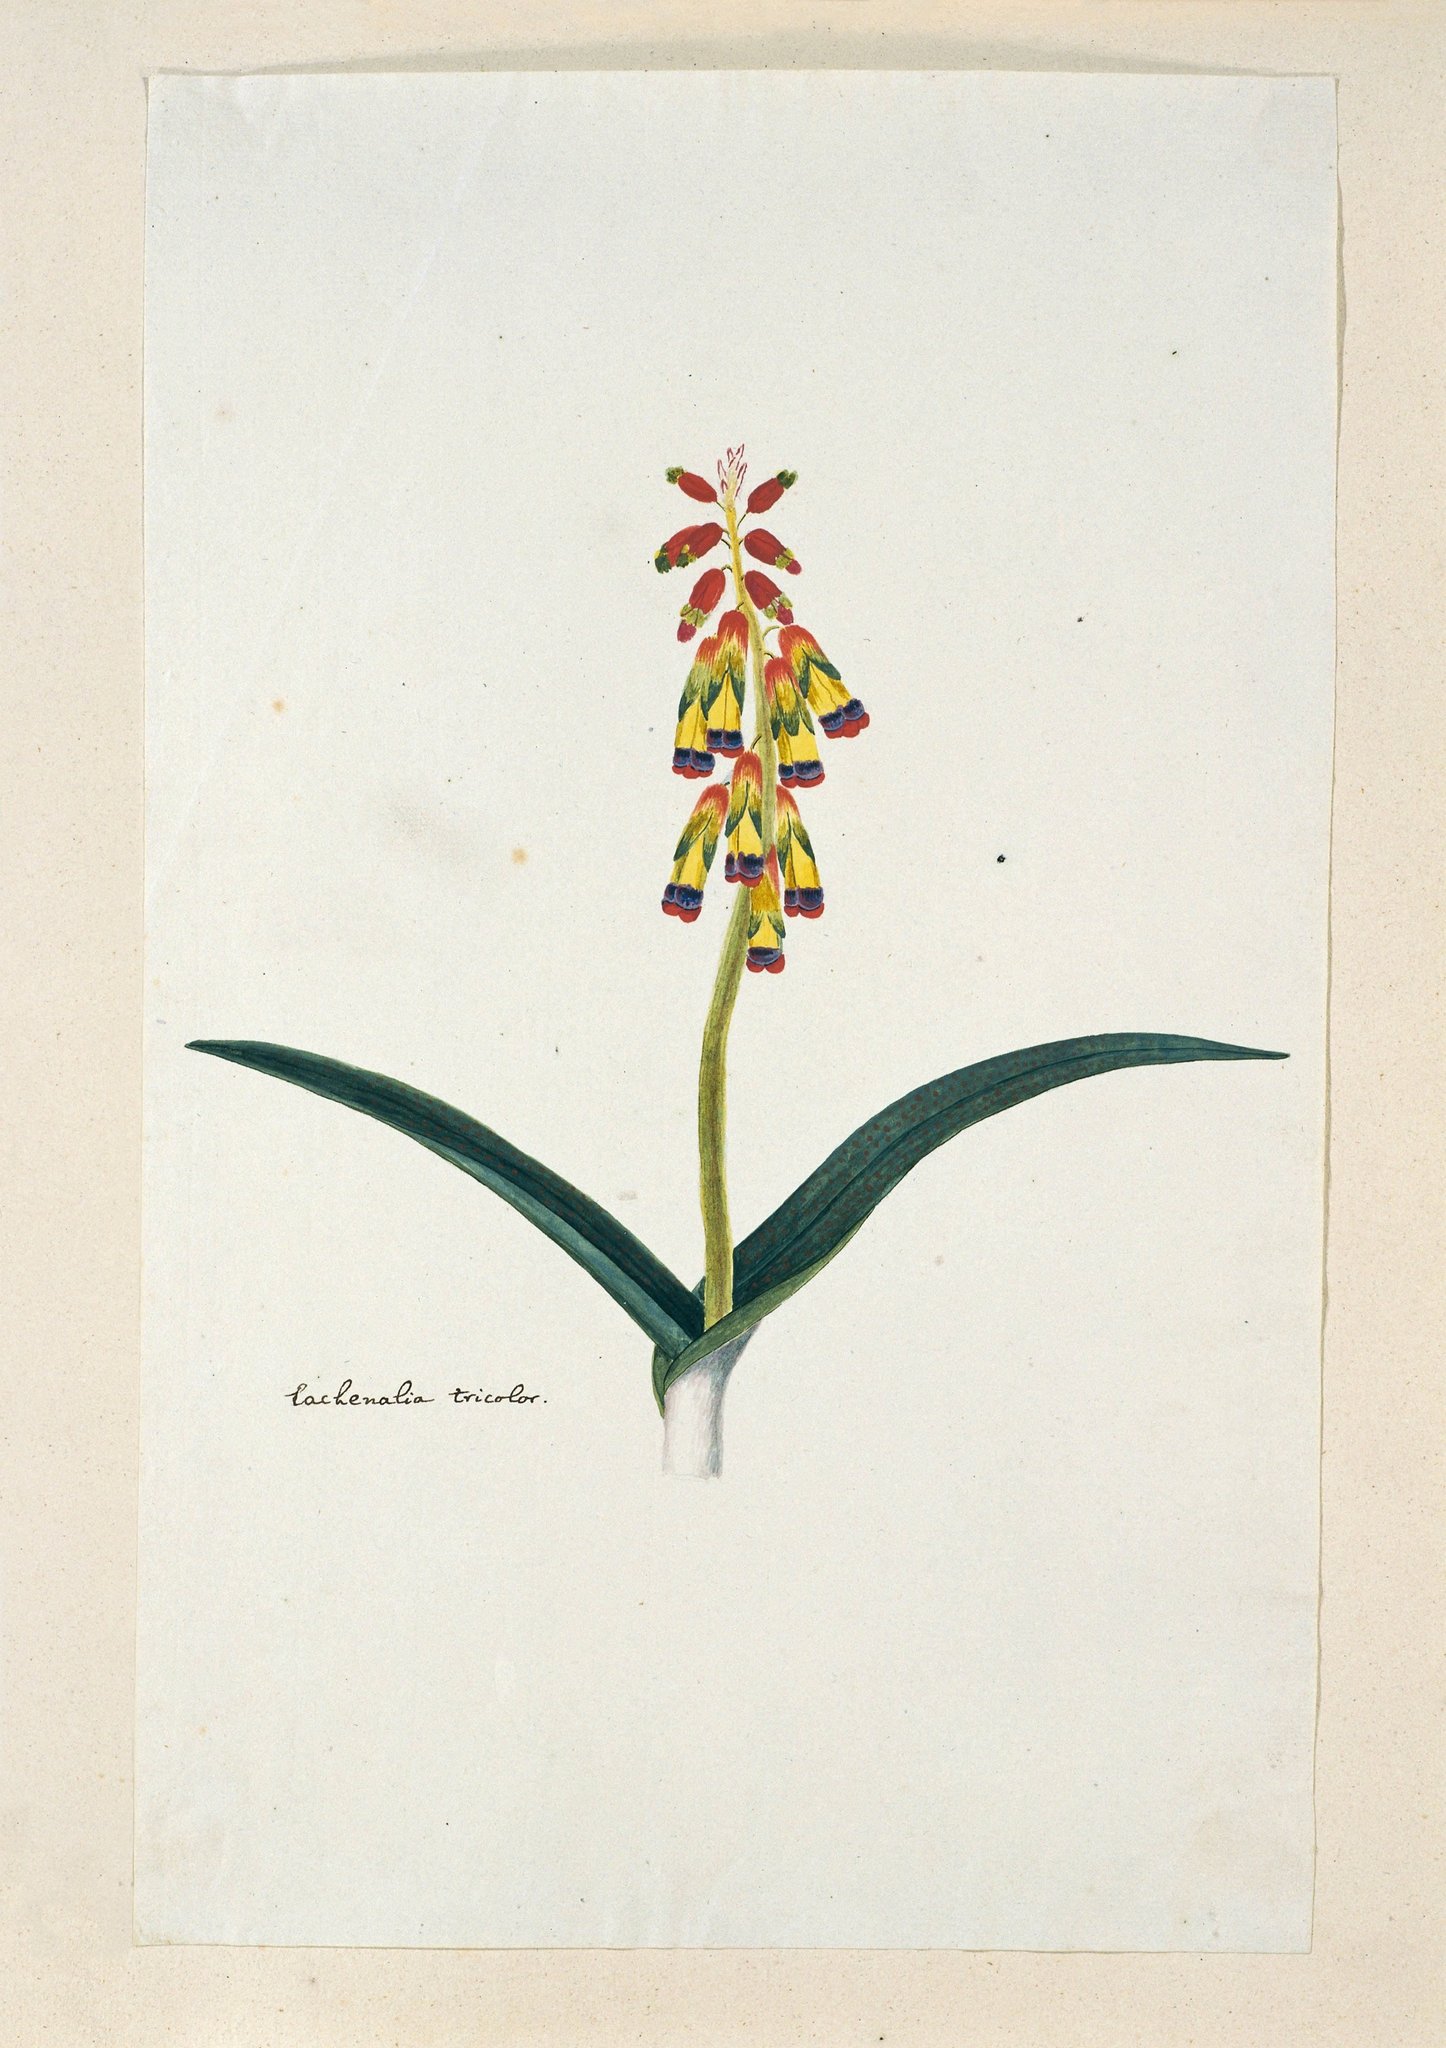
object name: album leaf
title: Lachenalia aloides (L.f.) Engl. var. quadricolor.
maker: robert jacob gordon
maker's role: draughtsman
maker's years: 1743-1795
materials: chalk, paint, ink, paper, pencil, watercolor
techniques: brush, pen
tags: plants; vegetation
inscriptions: annotation: ‘Lachenalia tricolor.’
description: De tekening is gemaakt voor of tijdens een van Gordon's vier expedities door de Kaapprovincie, van oktober 1777 tot maart 1786. Sommige (soort)namen kunnen zijn gewijzigd, gezien reorganisatie in plantentaxonomie gedurende de afgelopen jaren.